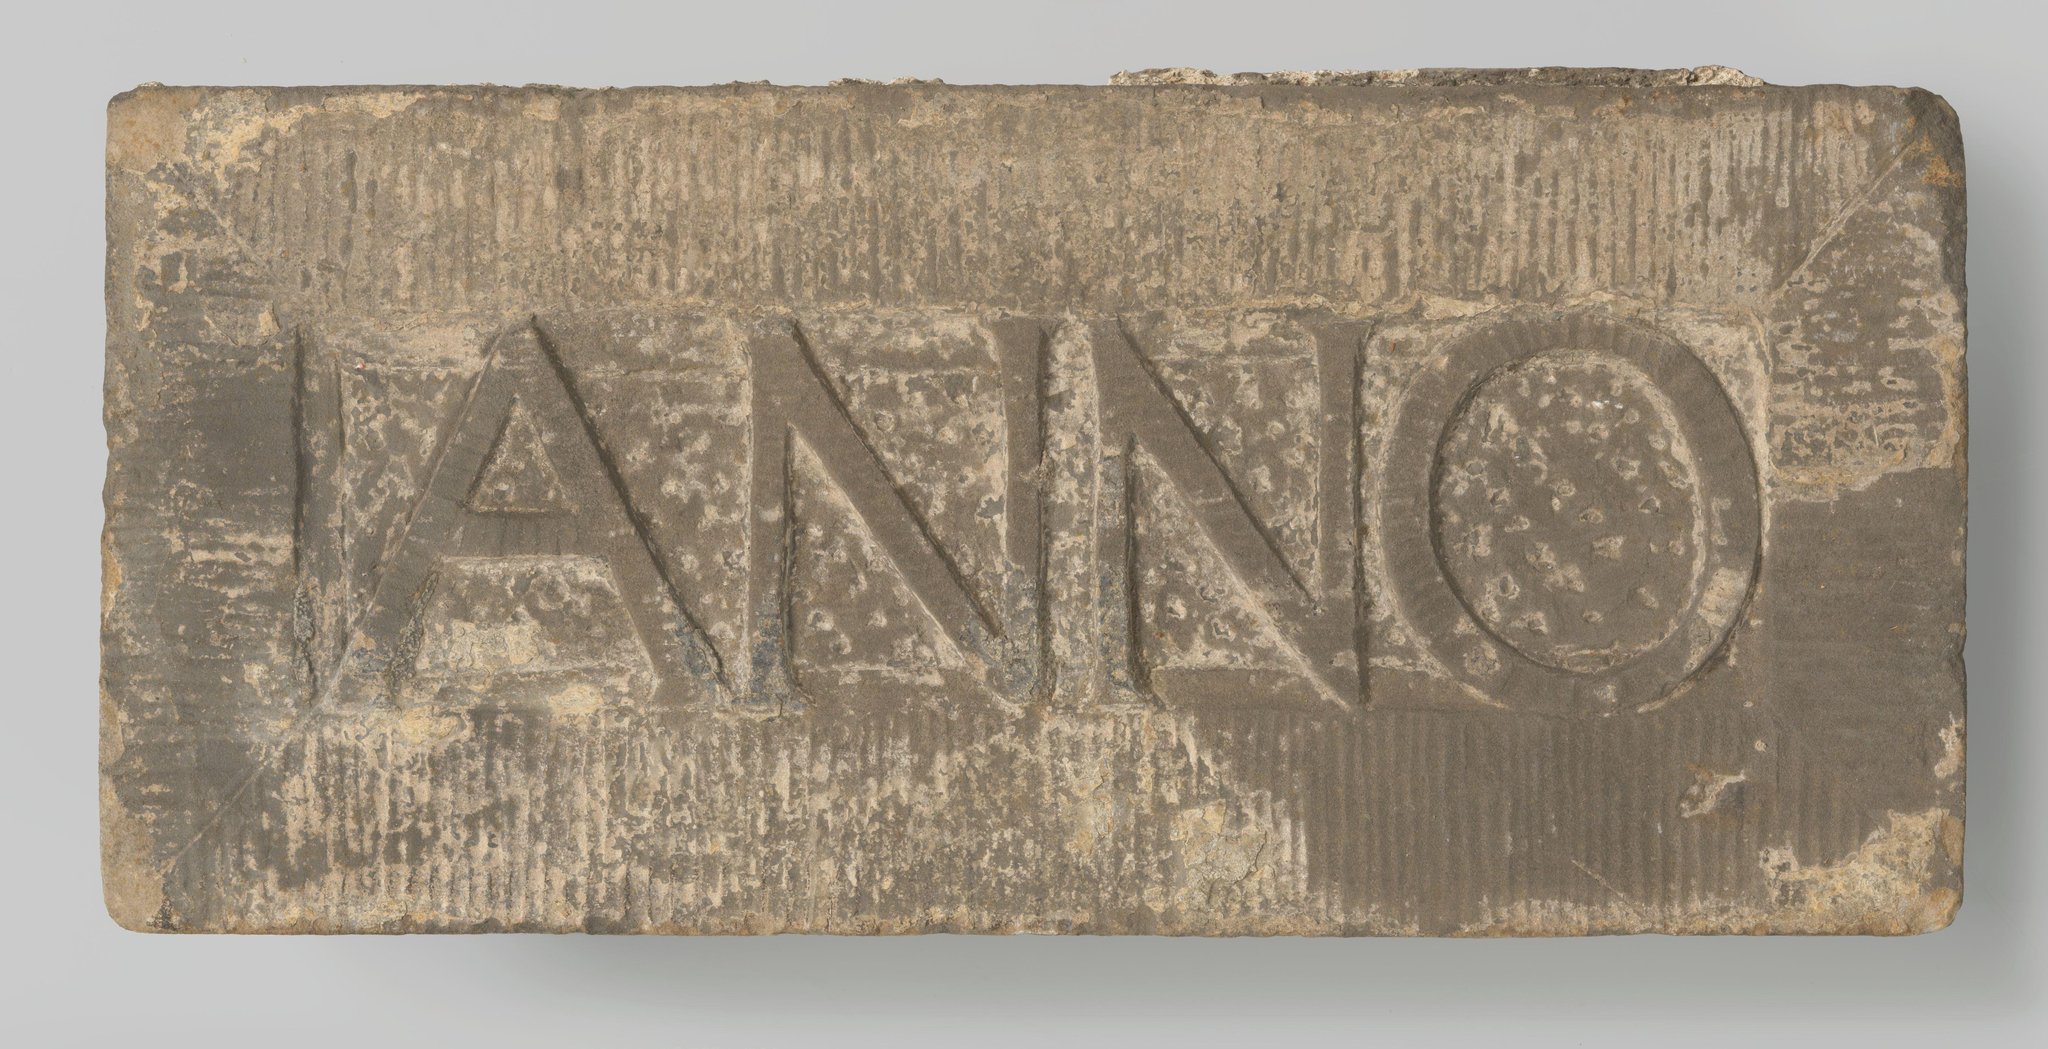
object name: gable stone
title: Gevelsteen met opschrift ANNO.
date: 1661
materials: stone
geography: netherlands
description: Liggende rechthoek met een brede gearceerde rand waarbinnen het opschrift ANNO. De gevelsteen hoort bij twee gevelstenen (KOG-ALS-144-1 met D LOOSMAN en KOG-ALS-144-3 met 1661).